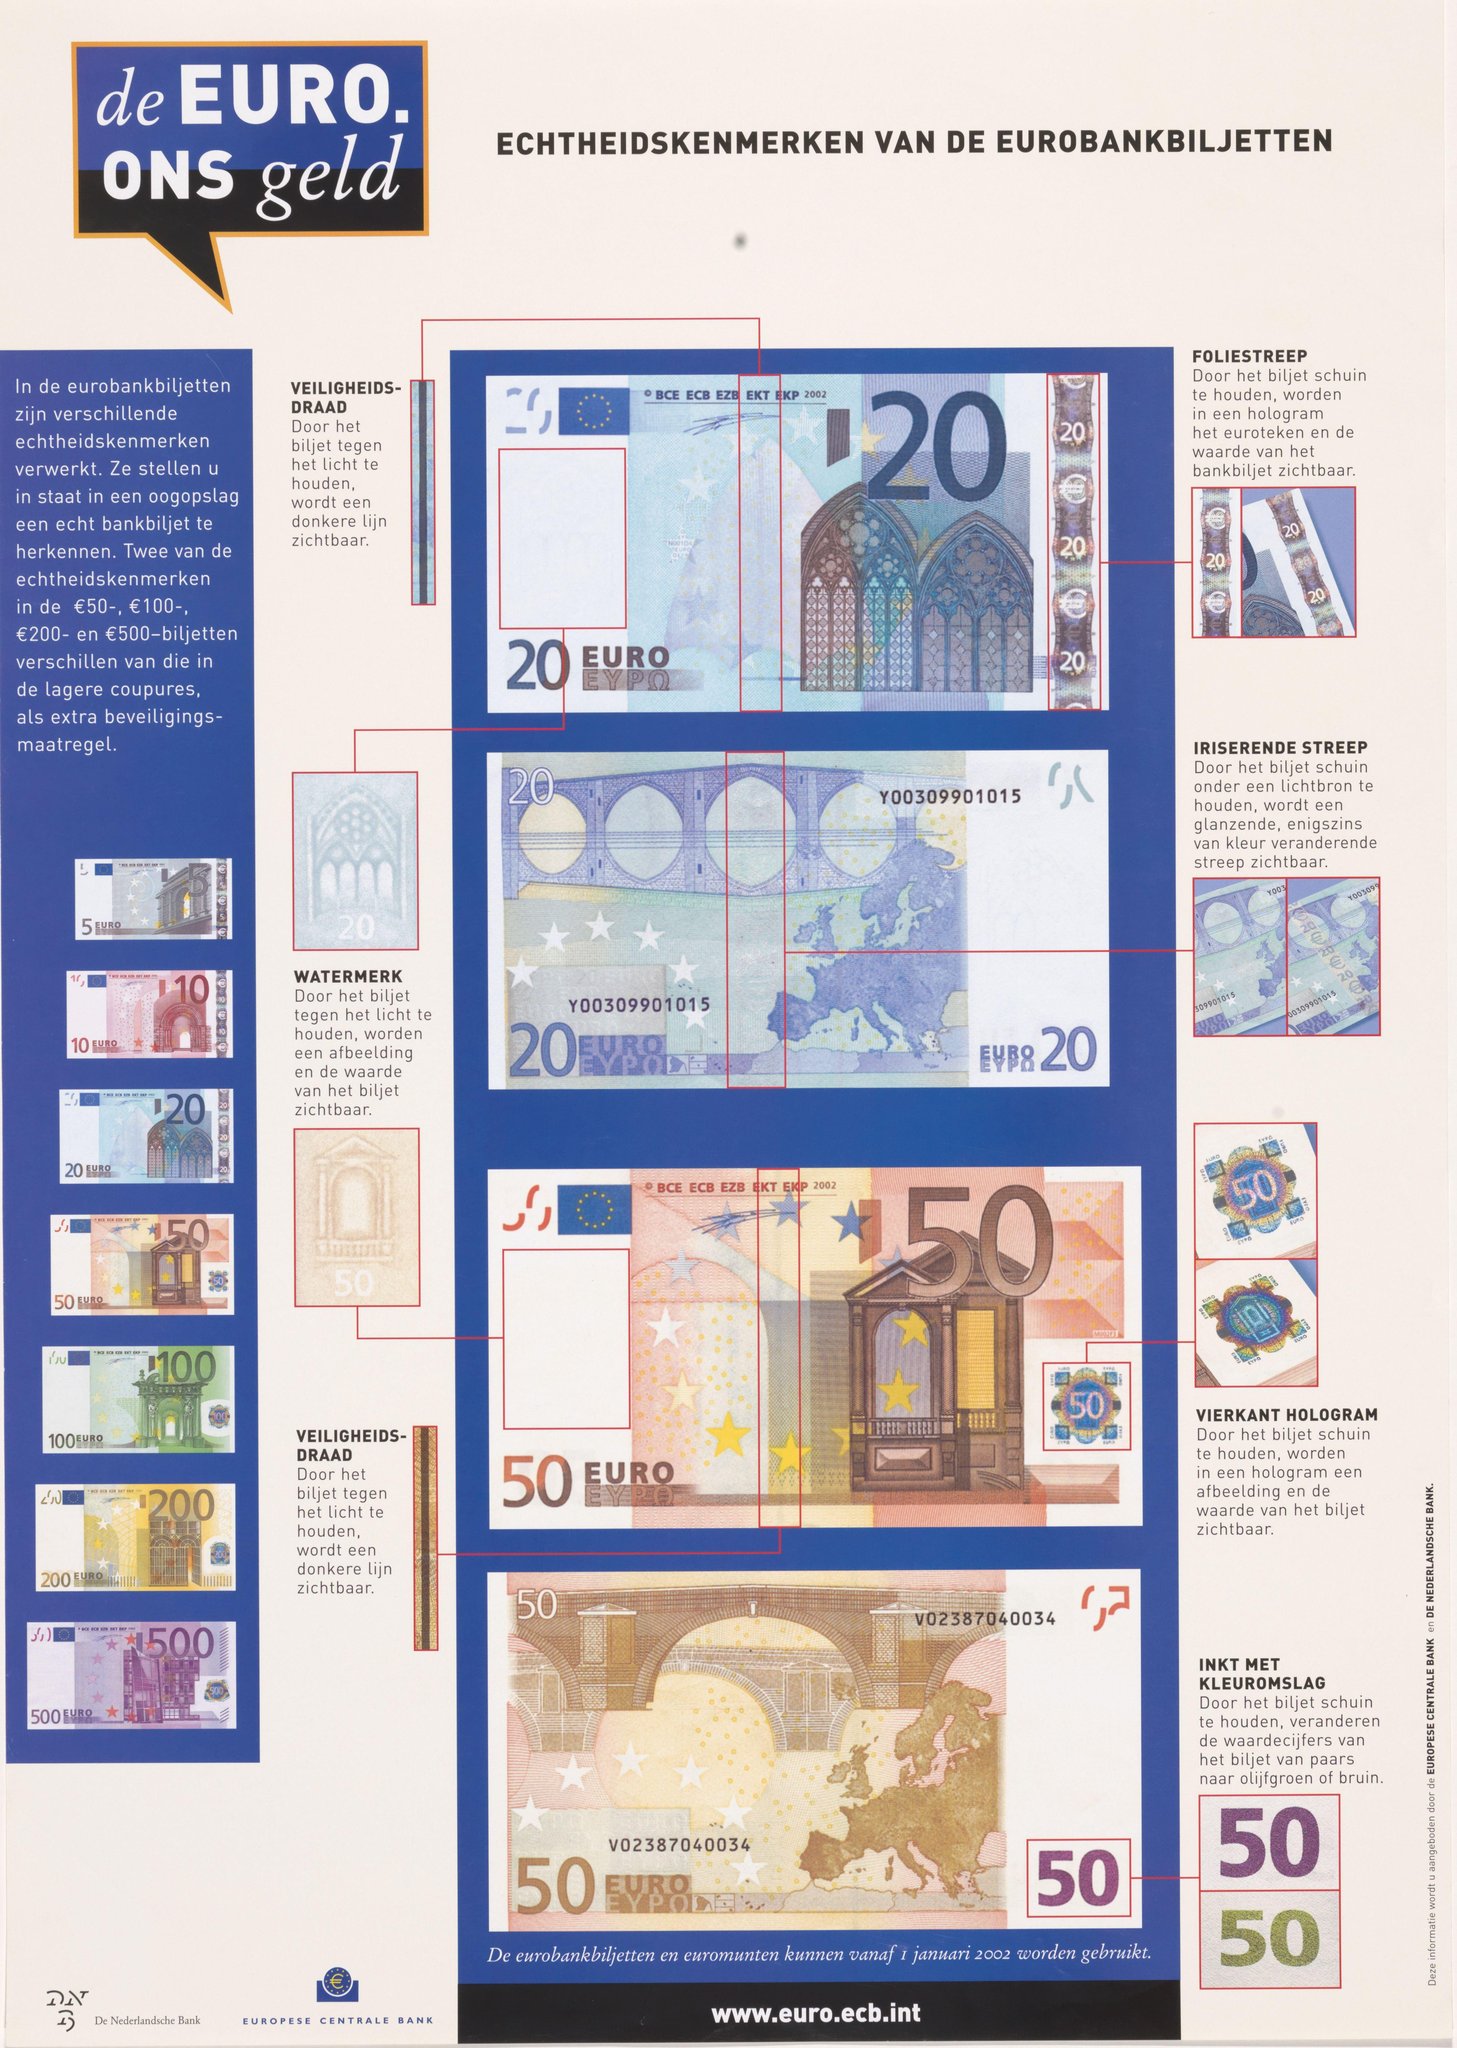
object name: poster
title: De EURO. ONS geld Echtheidskenmerken van de eurobankbiljetten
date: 2001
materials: paper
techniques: printing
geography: netherlands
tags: netherlands, europe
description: Eenzijdig gedrukt full-colour affiche waarop links alle bankbiljetten staan afgebeeld in blauw vlak. In het midden in blauw vlak zijn 2 bankbiljetten afgebeeld, zowel voor- als keerzijde van 20 en 50 EURO. Hierin zijn rode kaders geplaatst die verwijzen naar enkele kaders met de echtheidskenmerken, zowel links als rechts van het biljet. De echtheidskenmerken zijn de veiligheidsdraad, de foliestreep, het watermerk, de iriserende streep, de hologram en de inkt met kleuromslag. Bij elk kenmerk wordt een toelichting gegeven hoe deze te herkennen.